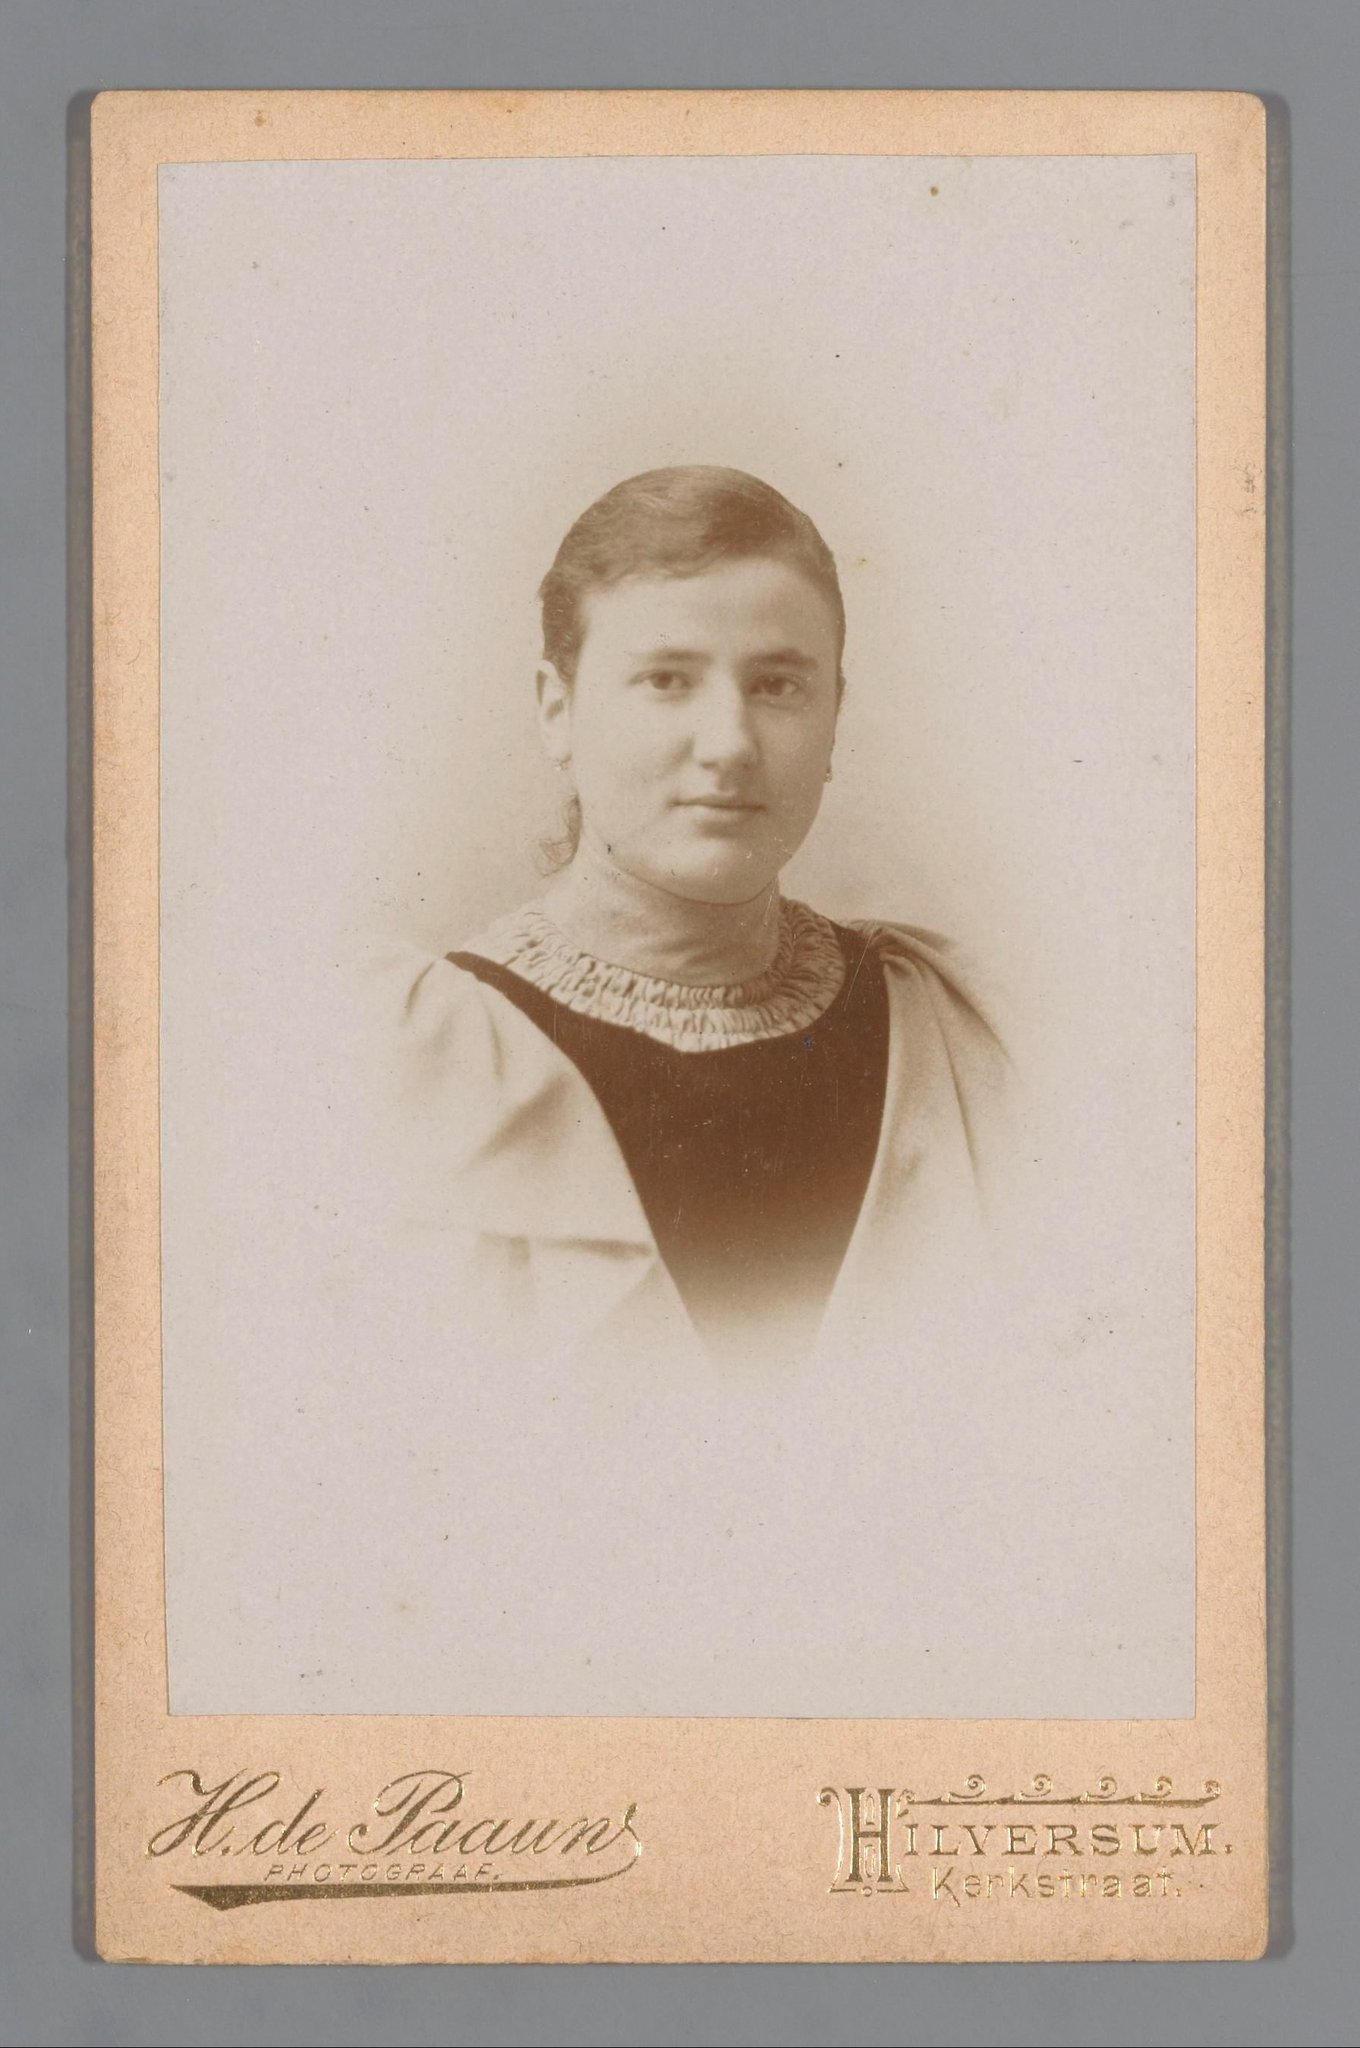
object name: photograph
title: Portret van een onbekende vrouw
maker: henri de paauw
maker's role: fotograaf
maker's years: 1849-1922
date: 1882-1903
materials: cardboard, paper, photographic support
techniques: daylight paper print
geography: hilversum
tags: adult woman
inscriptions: name: ‘H. de Paauw Photograaf Hilversum. Kerstraat.’